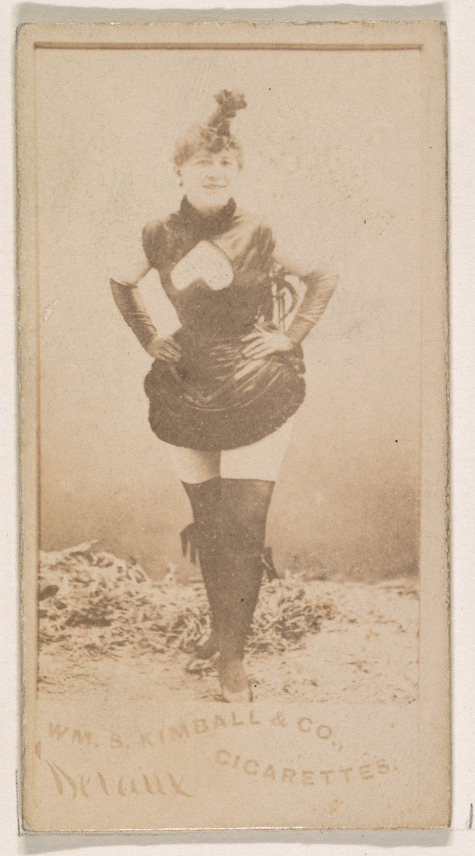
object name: photograph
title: Miss Devaux, from the Actresses series (N203) issued by Wm. S. Kimball & Co.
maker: william s. kimball & company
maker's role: publisher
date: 1889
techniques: color lithograph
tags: portraits,women,actresses